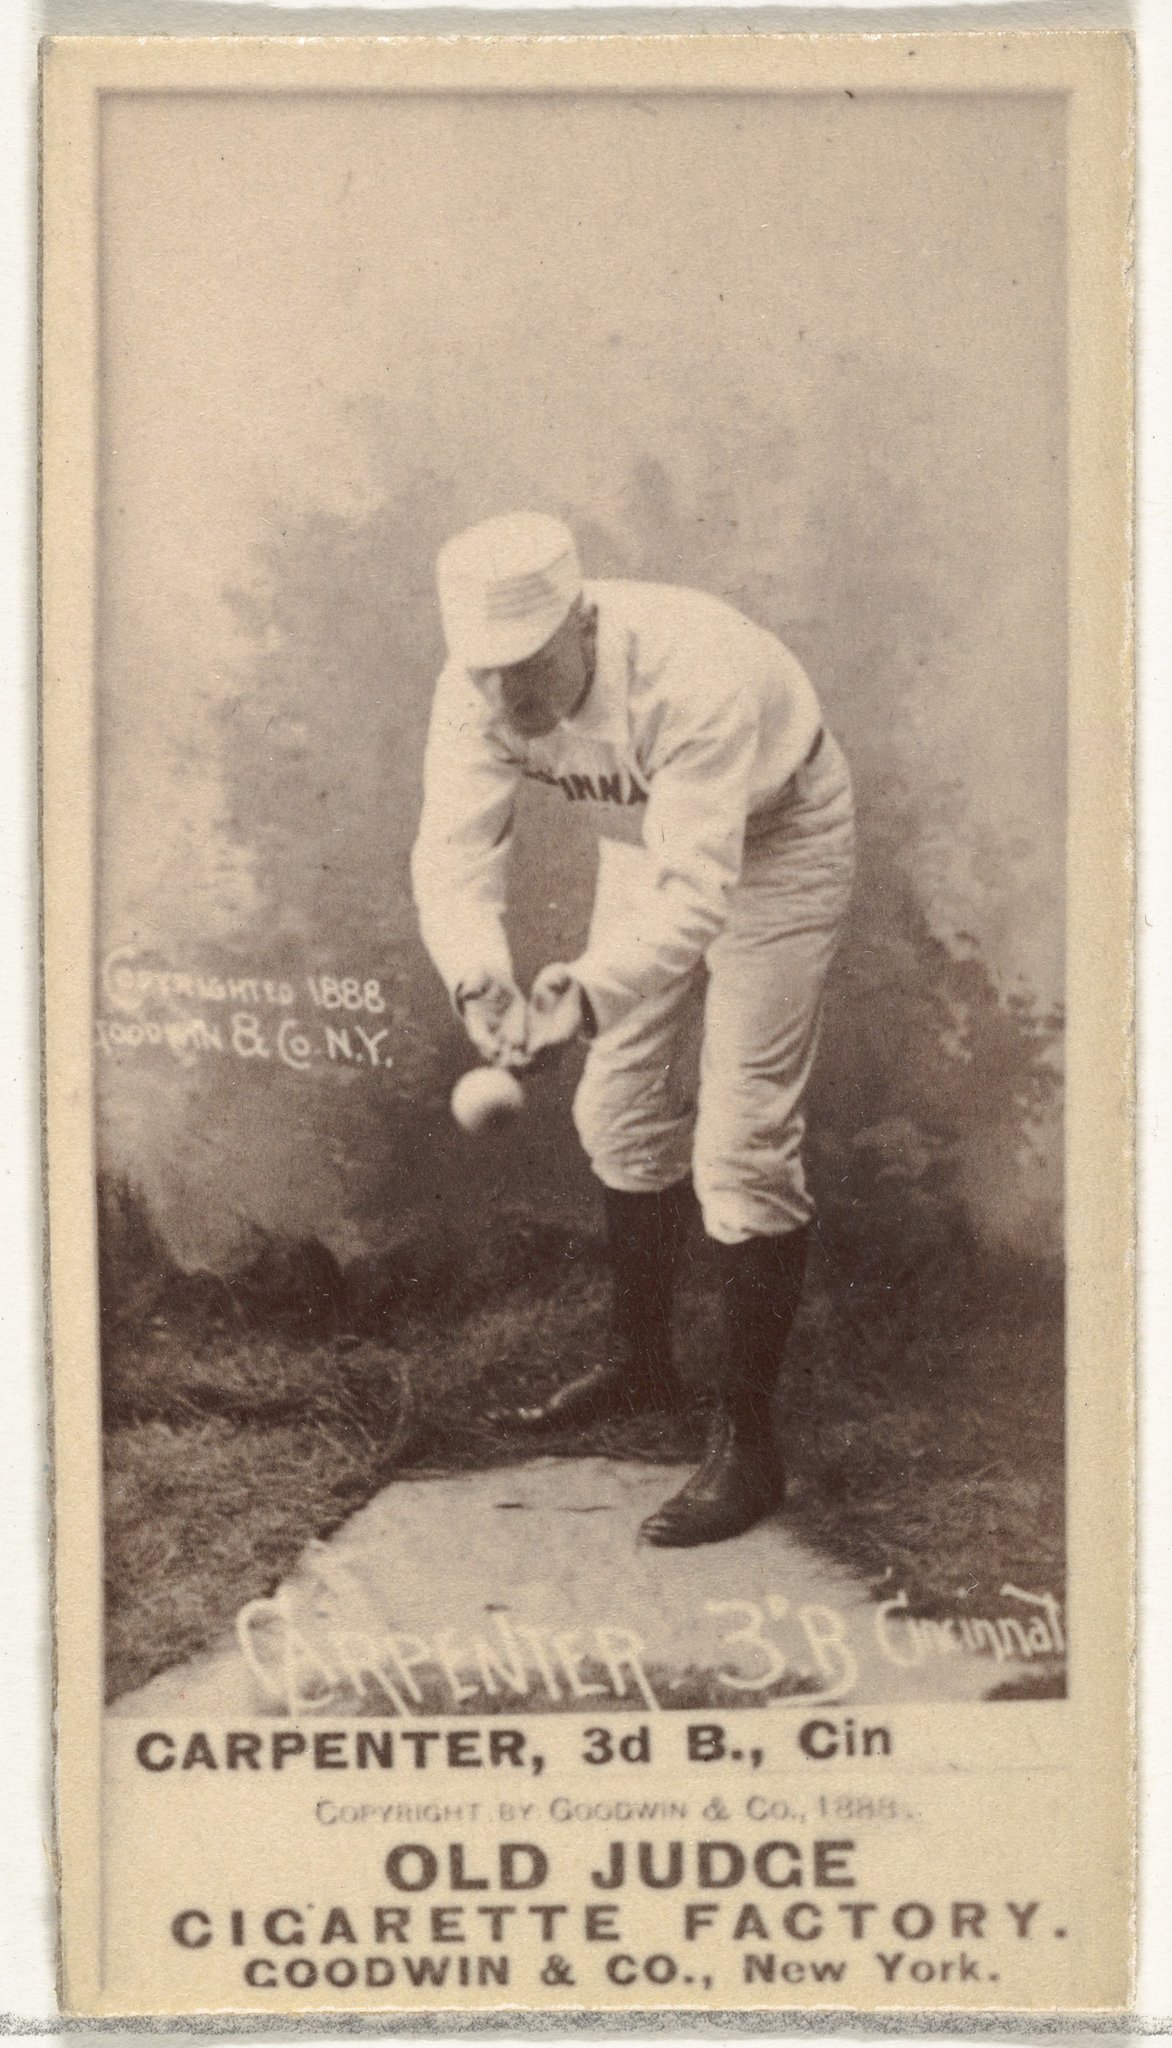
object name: baseball card, photograph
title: Warren William "Hick" Carpenter, 3rd Base, Cincinnati, from the Old Judge series (N172) for Old Judge Cigarettes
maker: goodwin & company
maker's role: publisher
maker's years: 1850-1950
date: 1888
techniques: albumen silver print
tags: men,portraits,baseball,athletes